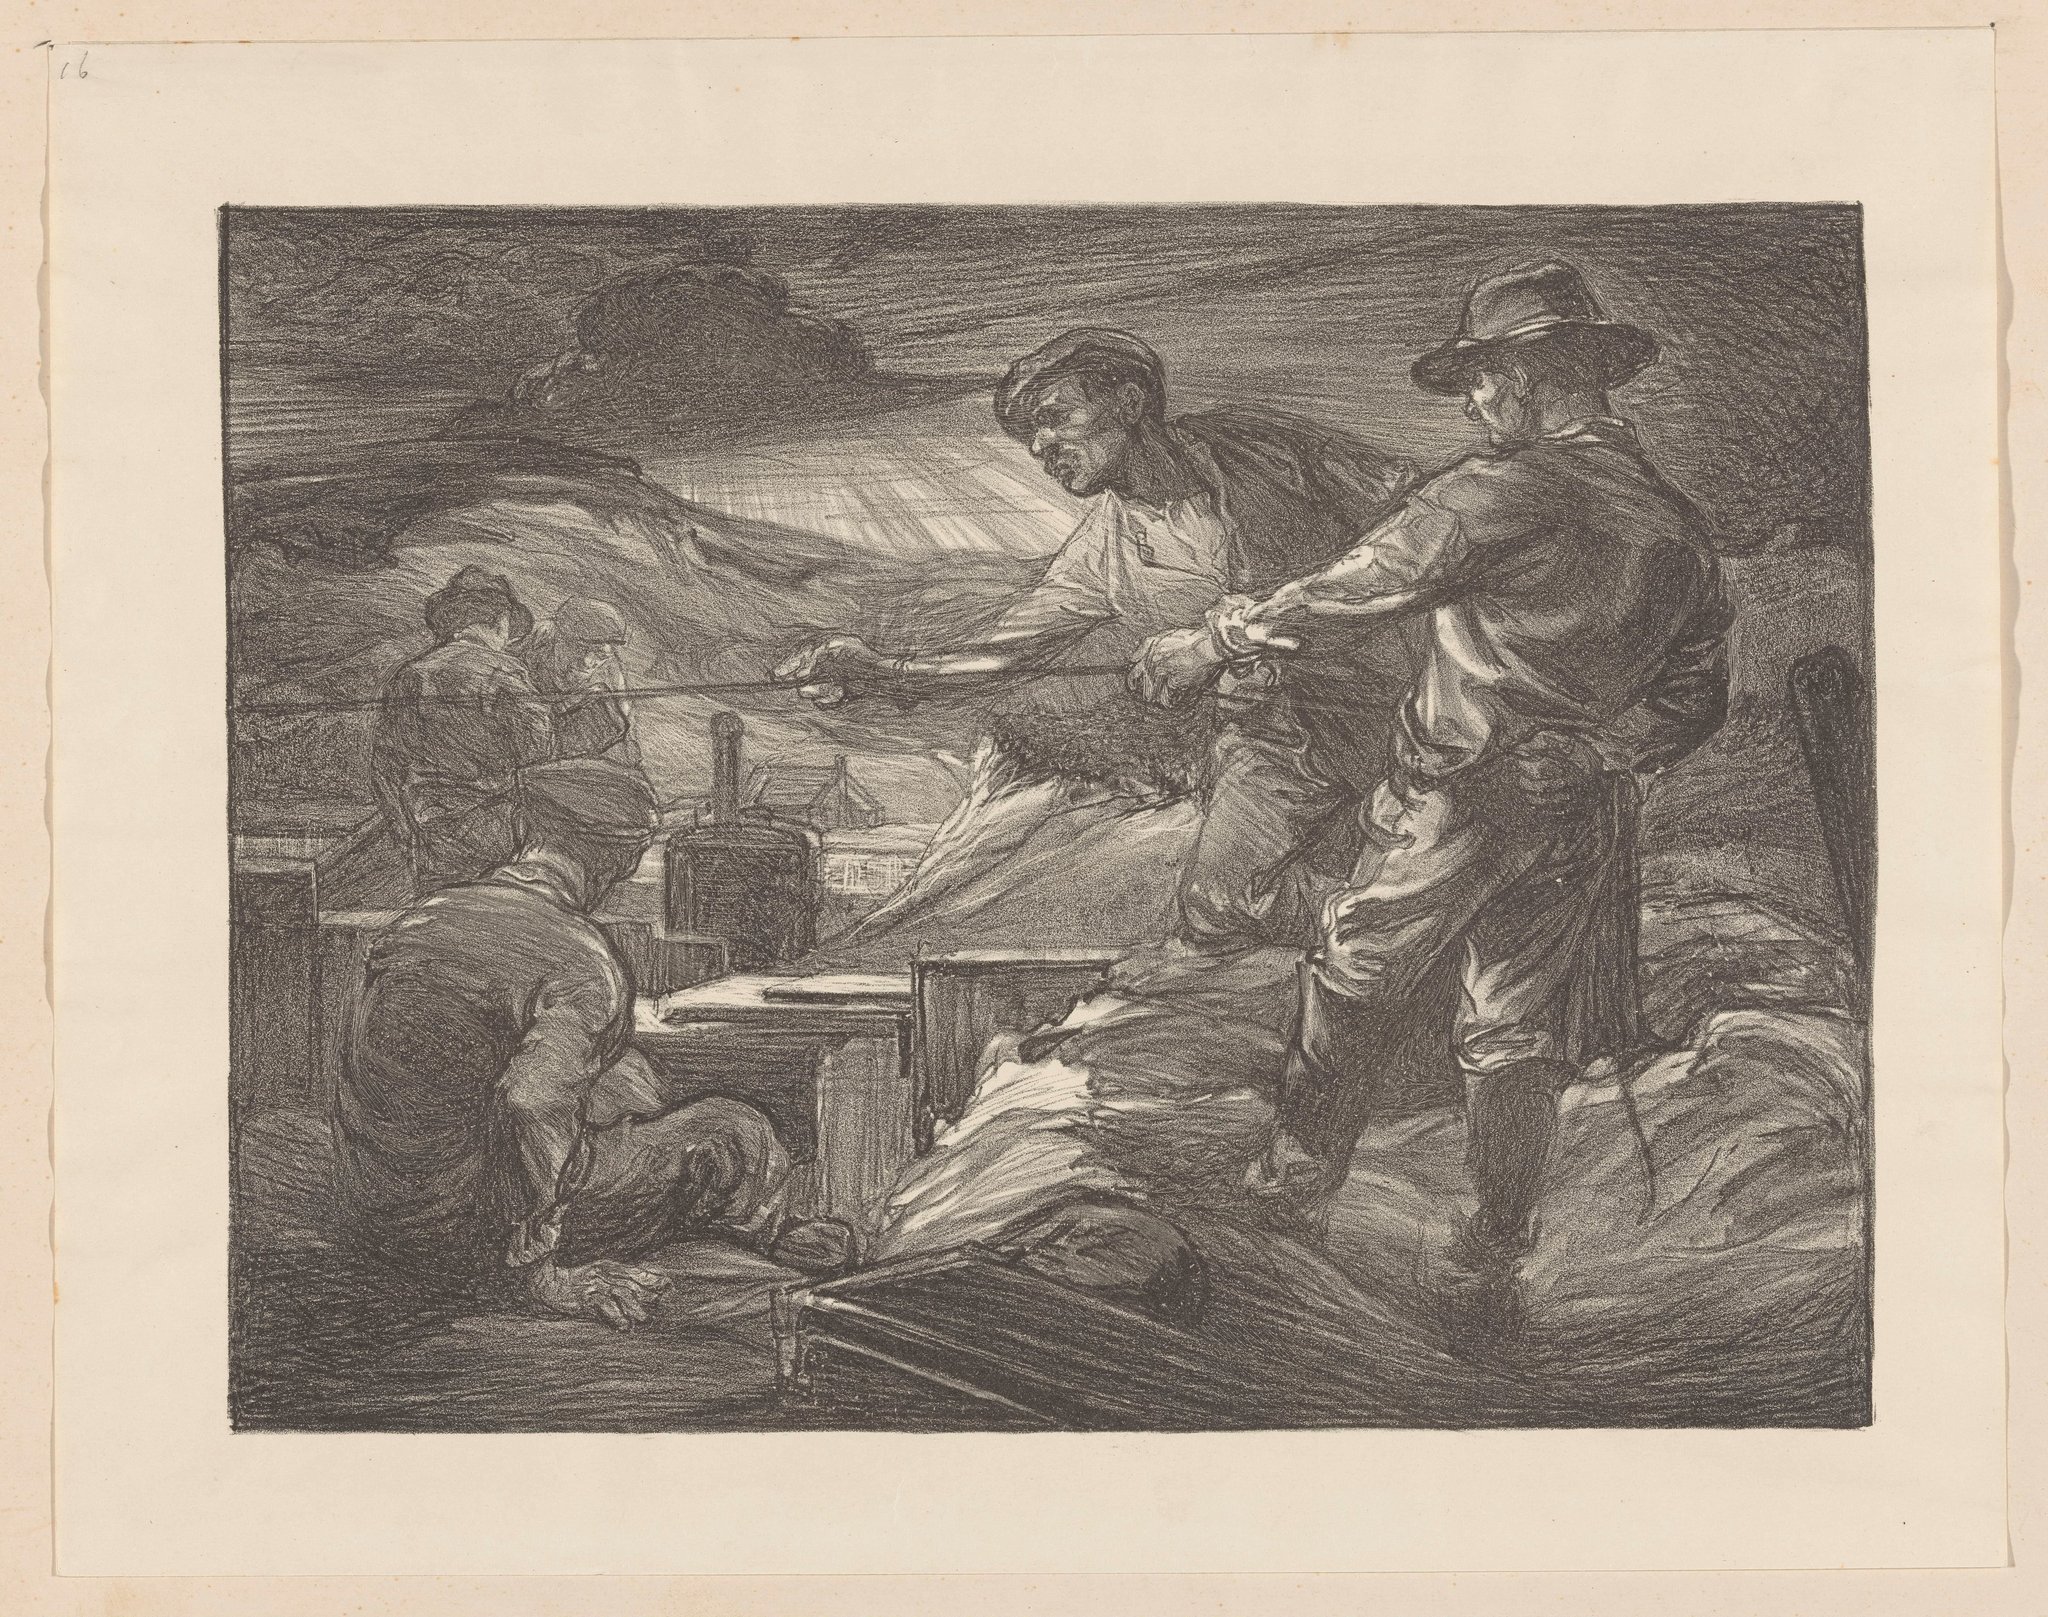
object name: print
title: Arbeiders die aan een touw trekken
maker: johannes josephus aarts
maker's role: draughtsman, print maker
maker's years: 1871-1934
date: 1881-1934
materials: paper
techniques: lithograph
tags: working class, labourers, tools, aids, implements ~ crafts and industries: rope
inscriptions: collector's mark, collector's mark: Lugt 2228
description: Een arbeider die een hoed en laarzen draagt heeft een strakgespannen touw in handen. Een arbeider met een pet pakt het touw ook vast. Links op de voorgrond een zittende arbeider en op de achtergrond een heuvel, een hut, een machine en twee staande arbeiders.